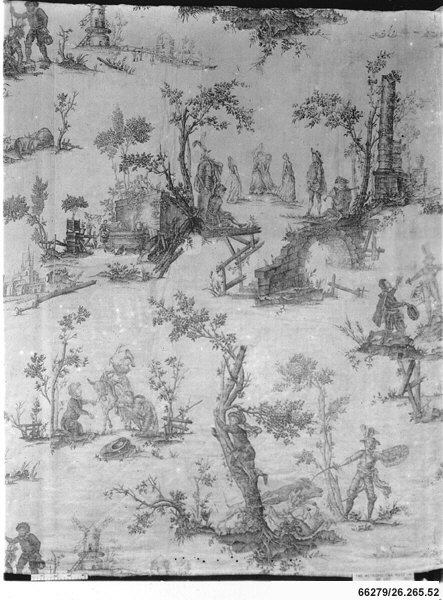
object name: furnishing textile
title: "Don Quixote"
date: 1785-1790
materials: linen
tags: animals,men,women,don quixote